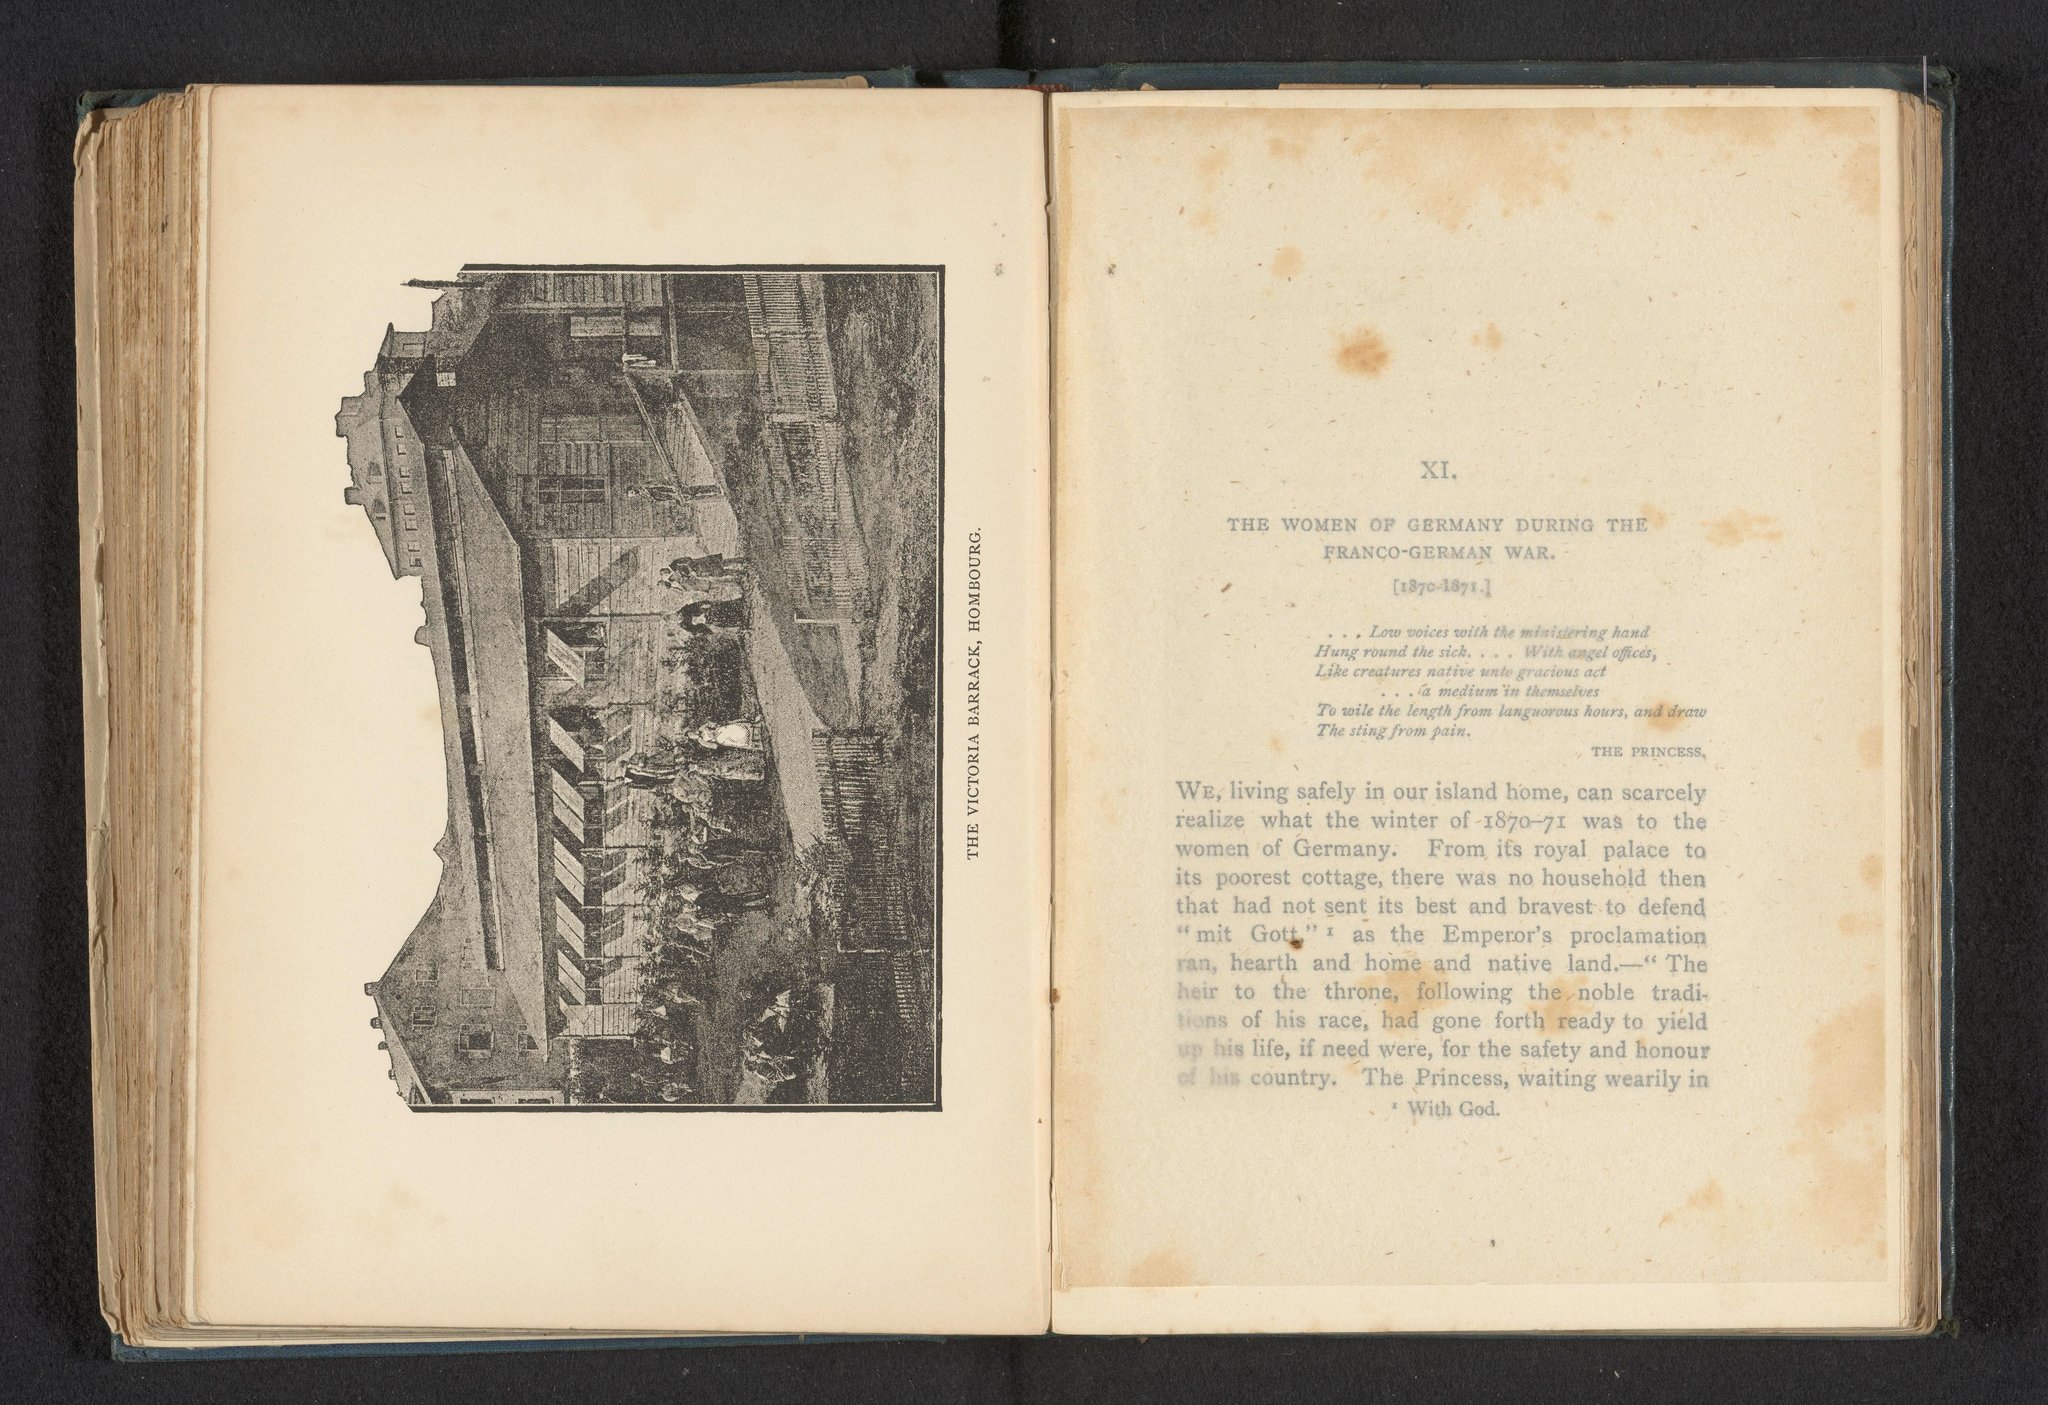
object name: photomechanical print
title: The Victoria barrack, Hombourg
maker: Anonymous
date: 1883-1888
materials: paper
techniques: autotype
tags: façade (of house or building), barracks